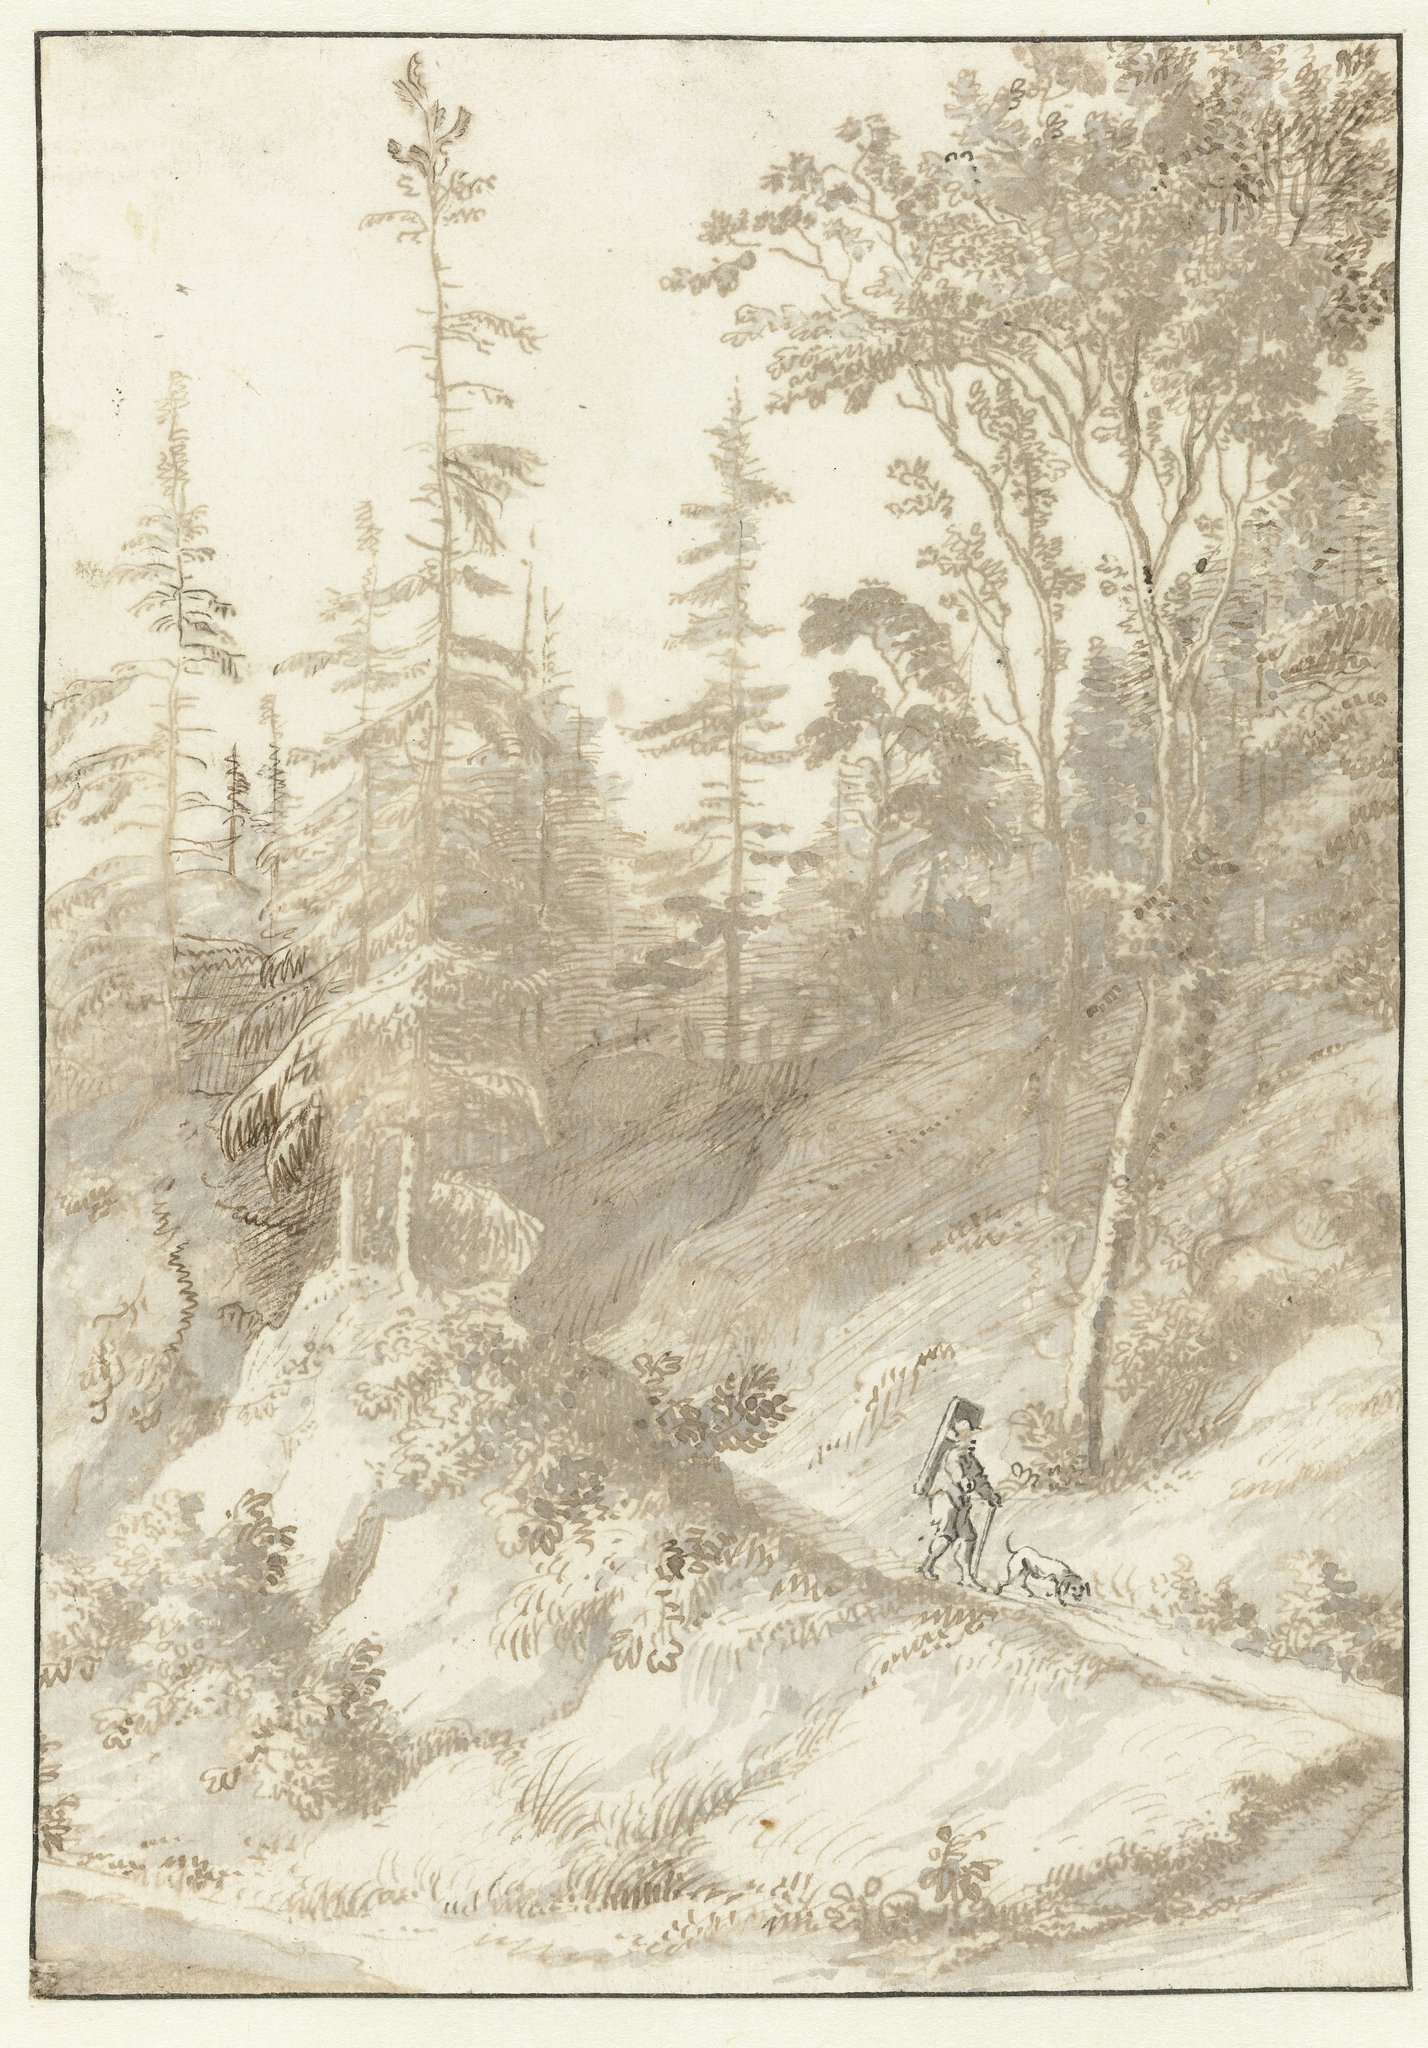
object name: drawing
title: Boslandschap met een reiziger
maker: allaert van everdingen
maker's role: draughtsman, painter, print maker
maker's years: 1621-1675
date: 1631-1675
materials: ink, paper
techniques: brush, pen